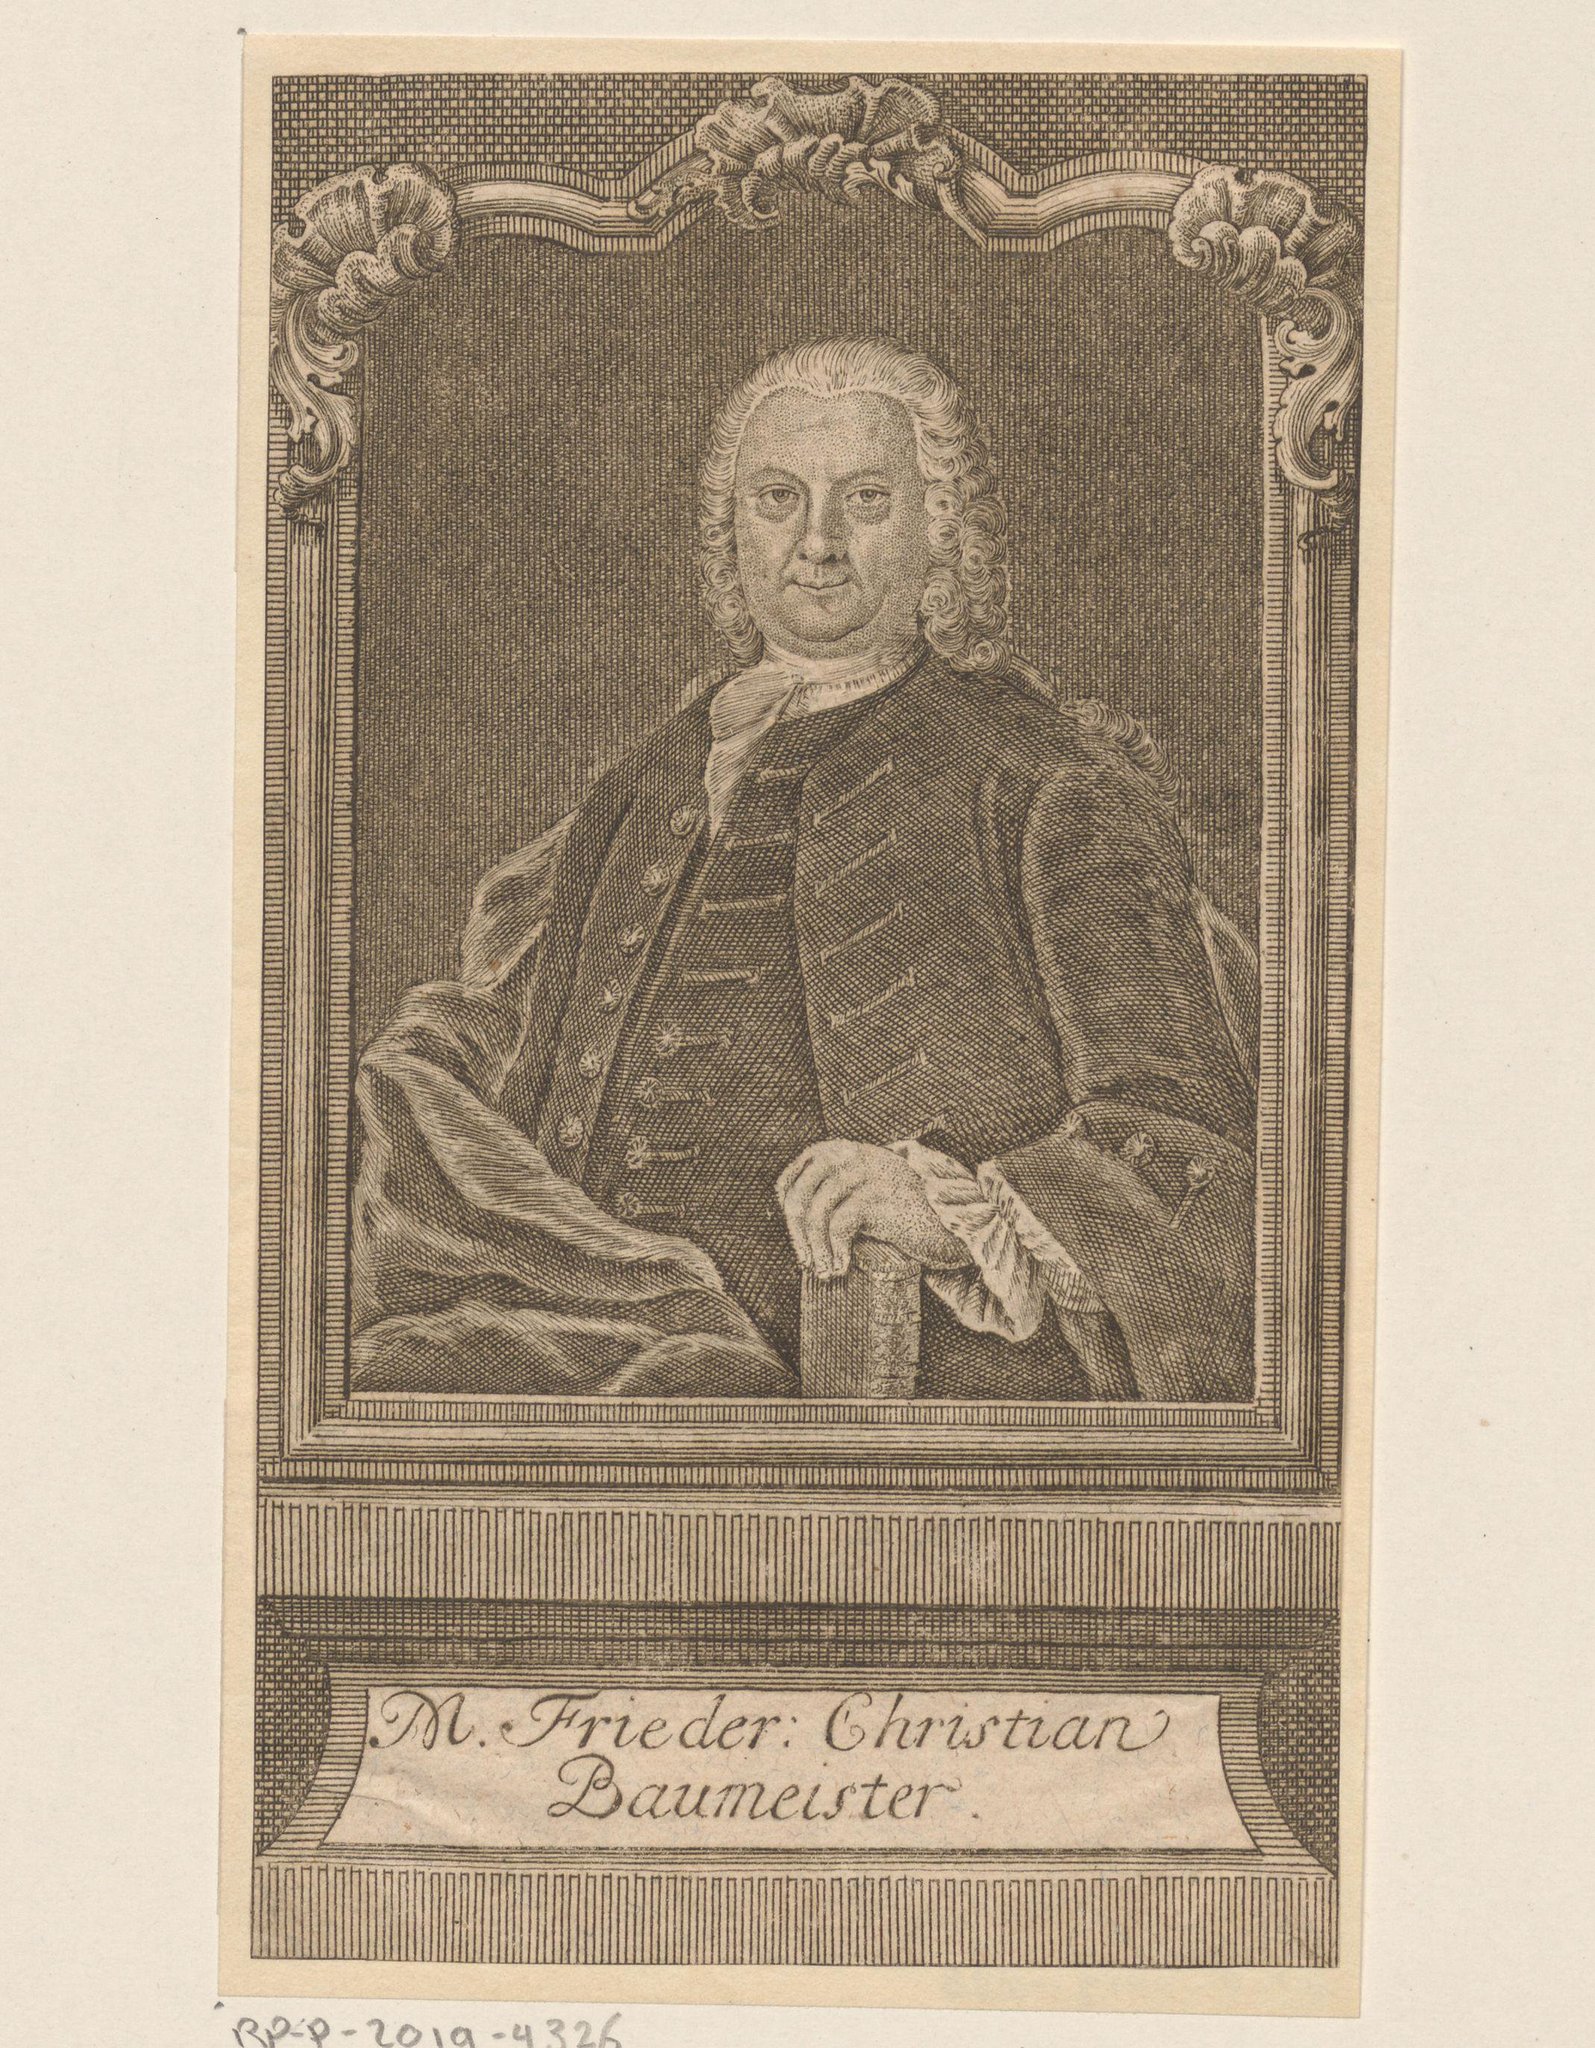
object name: print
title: Portret van Friedrich Christian Baumeister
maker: johann christoph sysang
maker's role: print maker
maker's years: 1703-1757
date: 1720-1757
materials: paper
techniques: engraving, etching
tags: historical persons